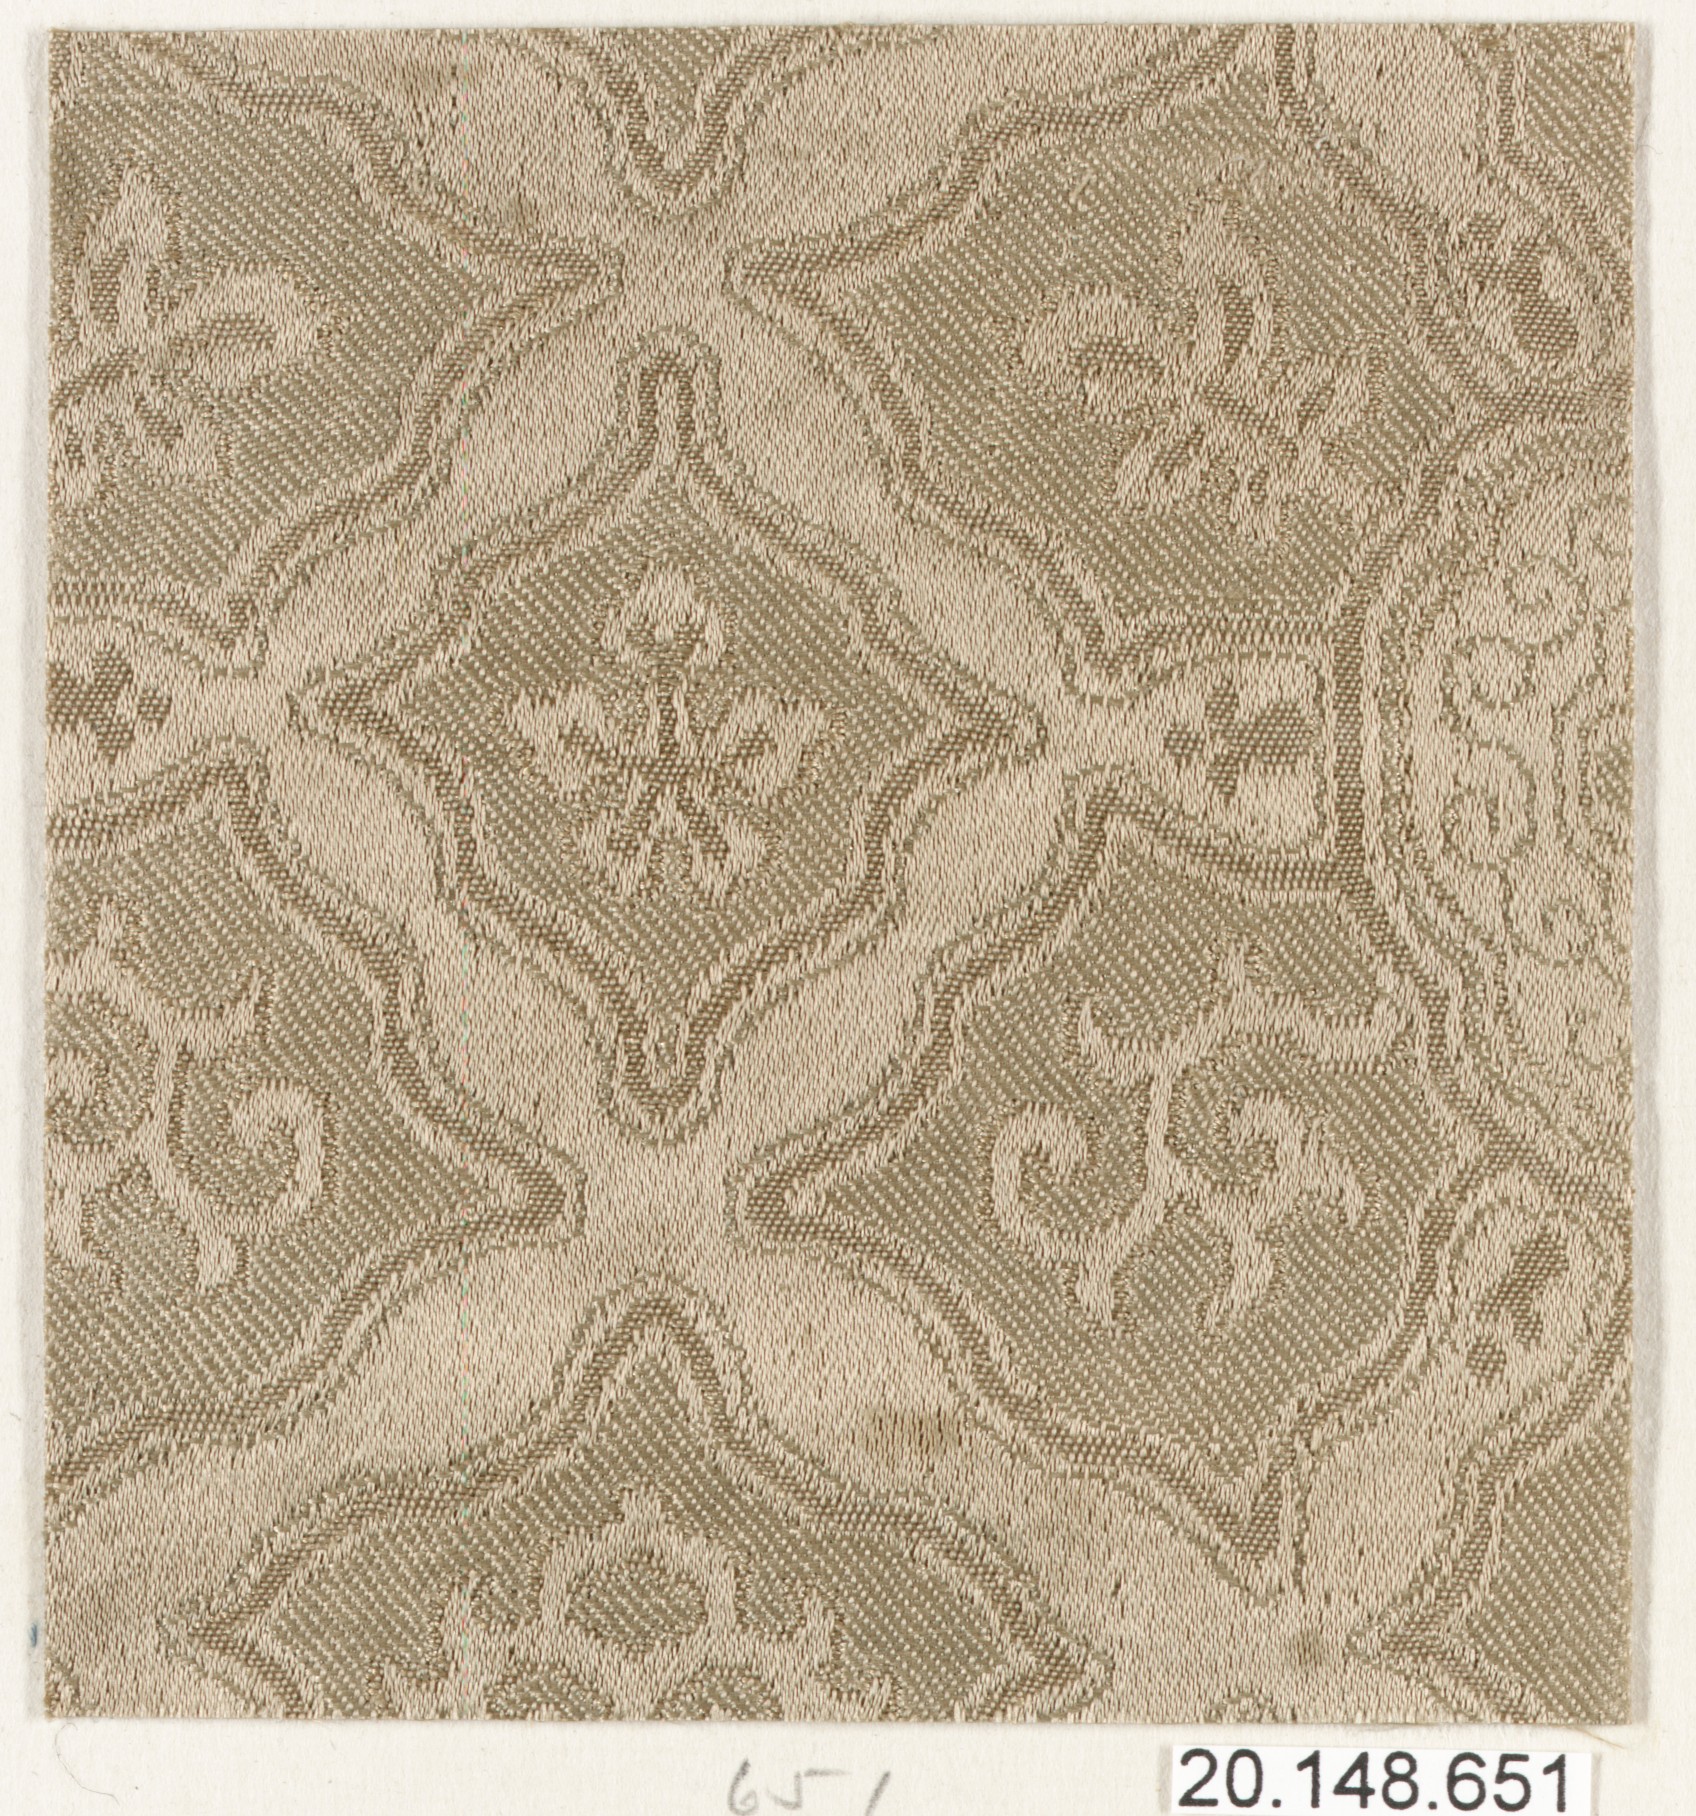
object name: piece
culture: japanese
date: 1701-1800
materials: silk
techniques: compound weave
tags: leaves